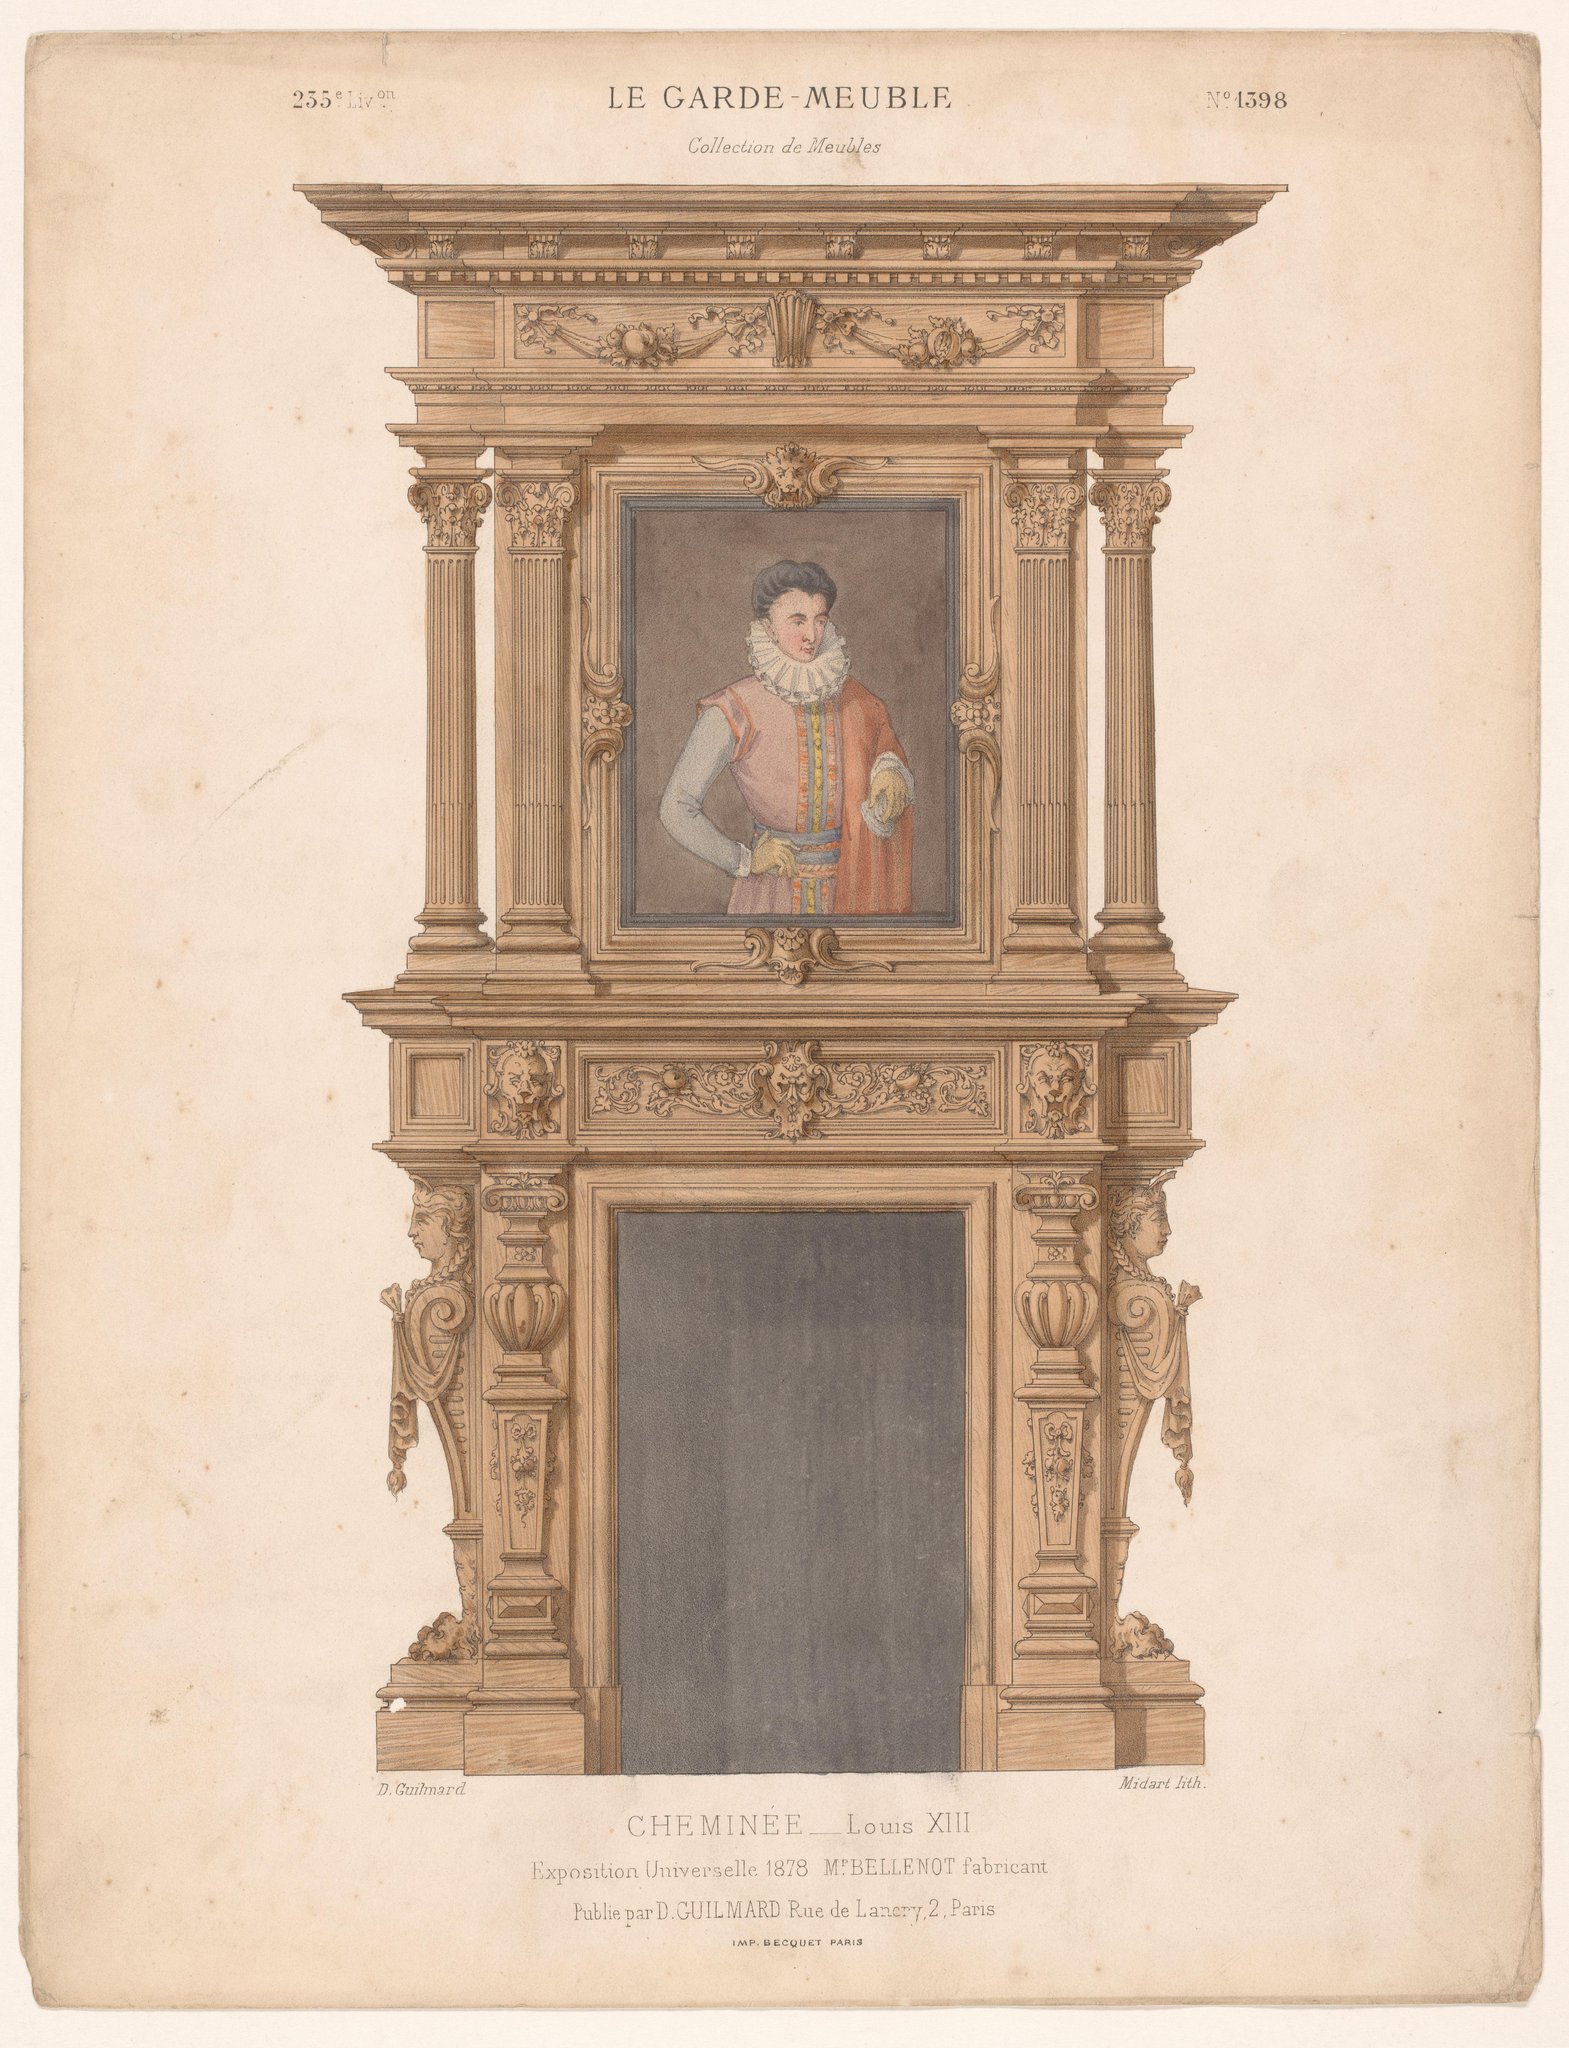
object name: print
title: Cheminee Louis XIII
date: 1839-1885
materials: paper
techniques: hand coloring, lithograph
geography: paris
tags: chimney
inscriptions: stamp: ‘H.F. Jansen en Zn’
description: Ieder Livraison in de serie Le Garde-Meuble bevat negen platen: drie 'sièges' (zitmeubels), drie 'meubles' (diverse meubels zoals tafels en kasten) en drie 'tentures' (gordijnen en draperieën).